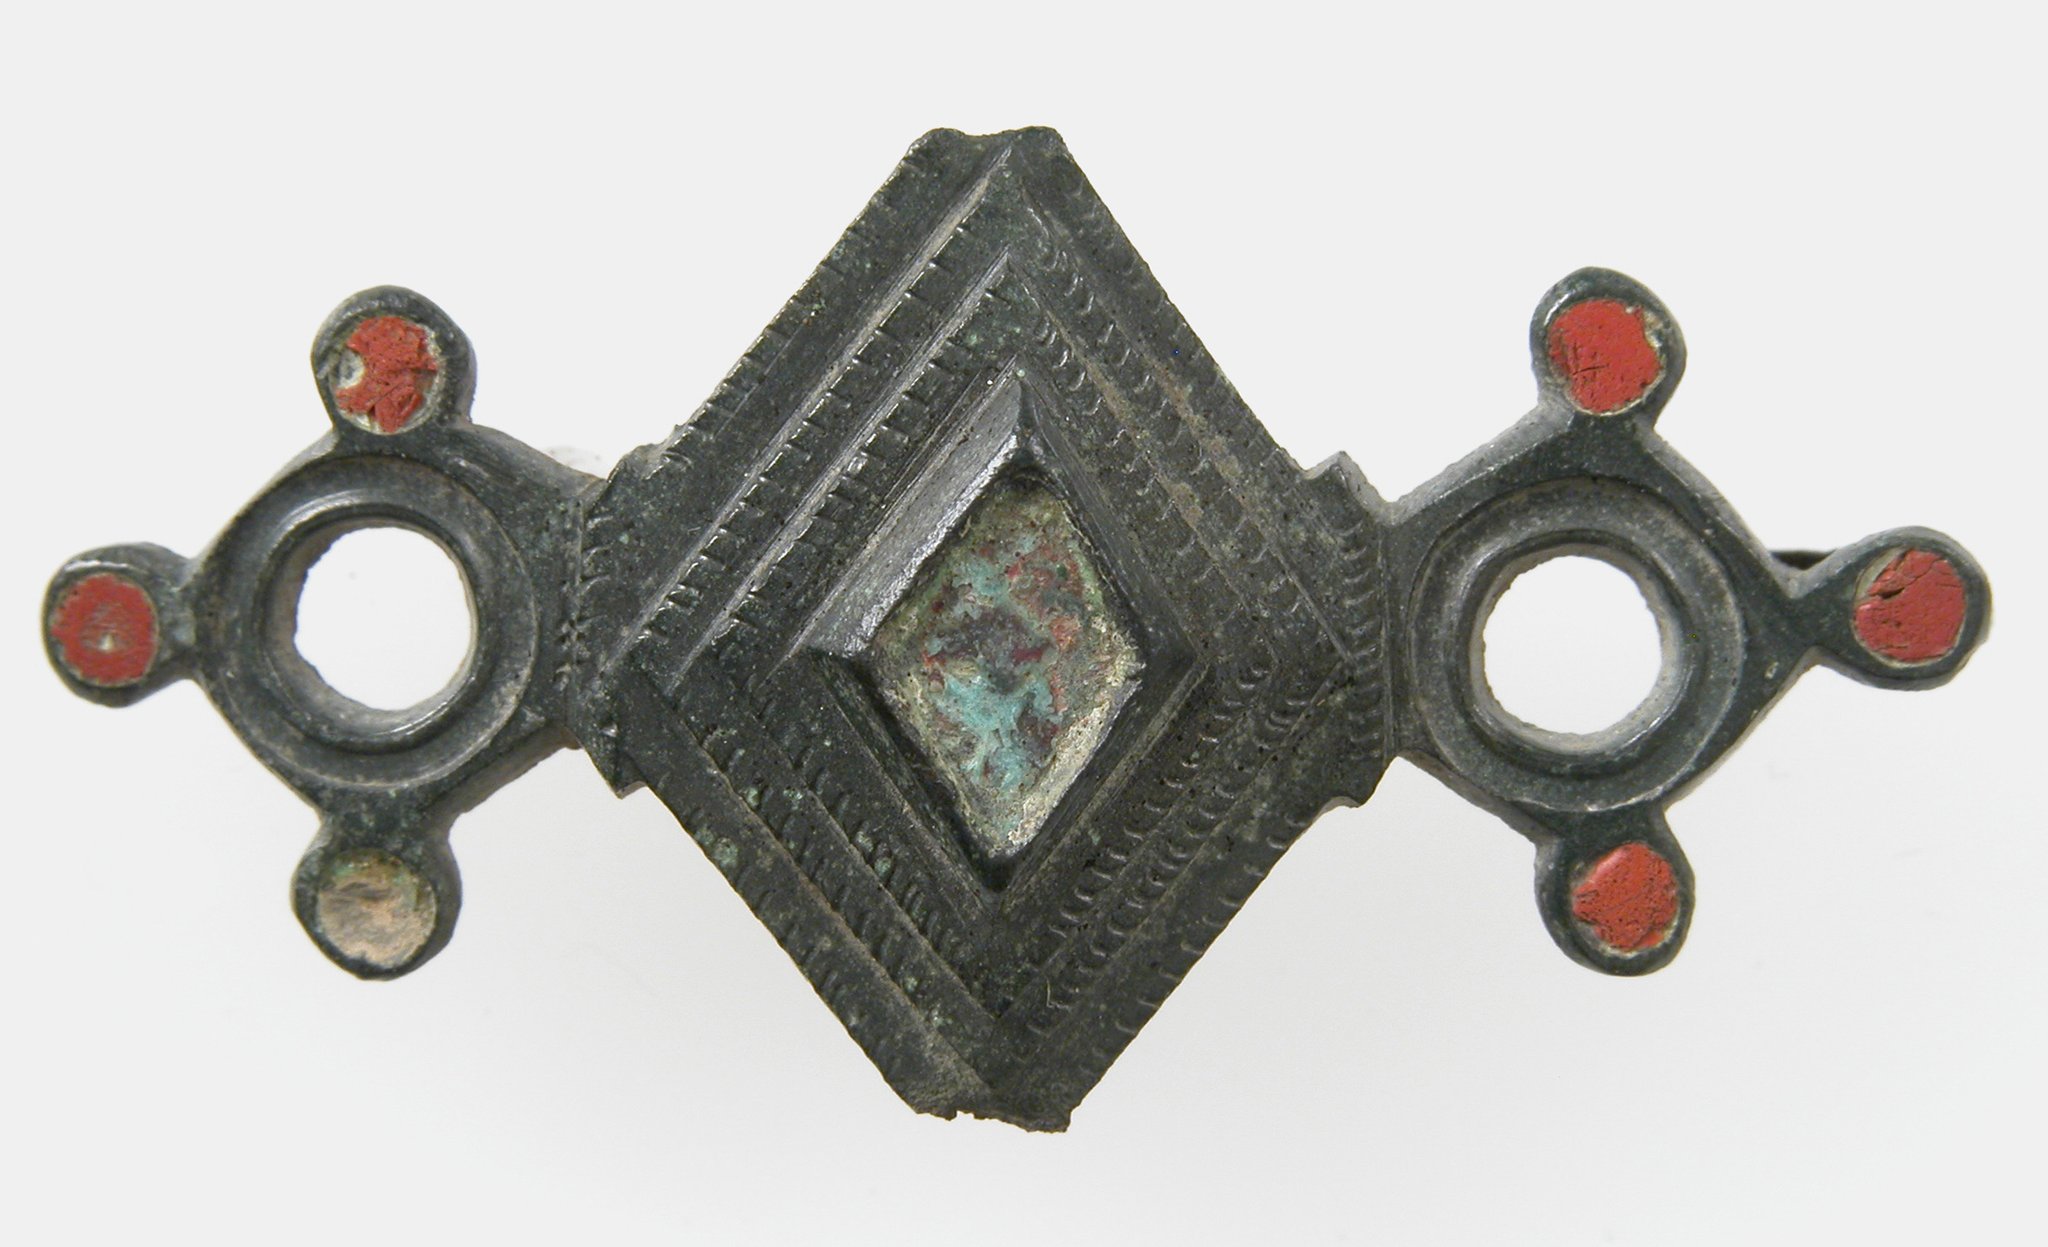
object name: brooch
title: Openwork Brooch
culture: roman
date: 201-300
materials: copper alloy, enamel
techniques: enamel